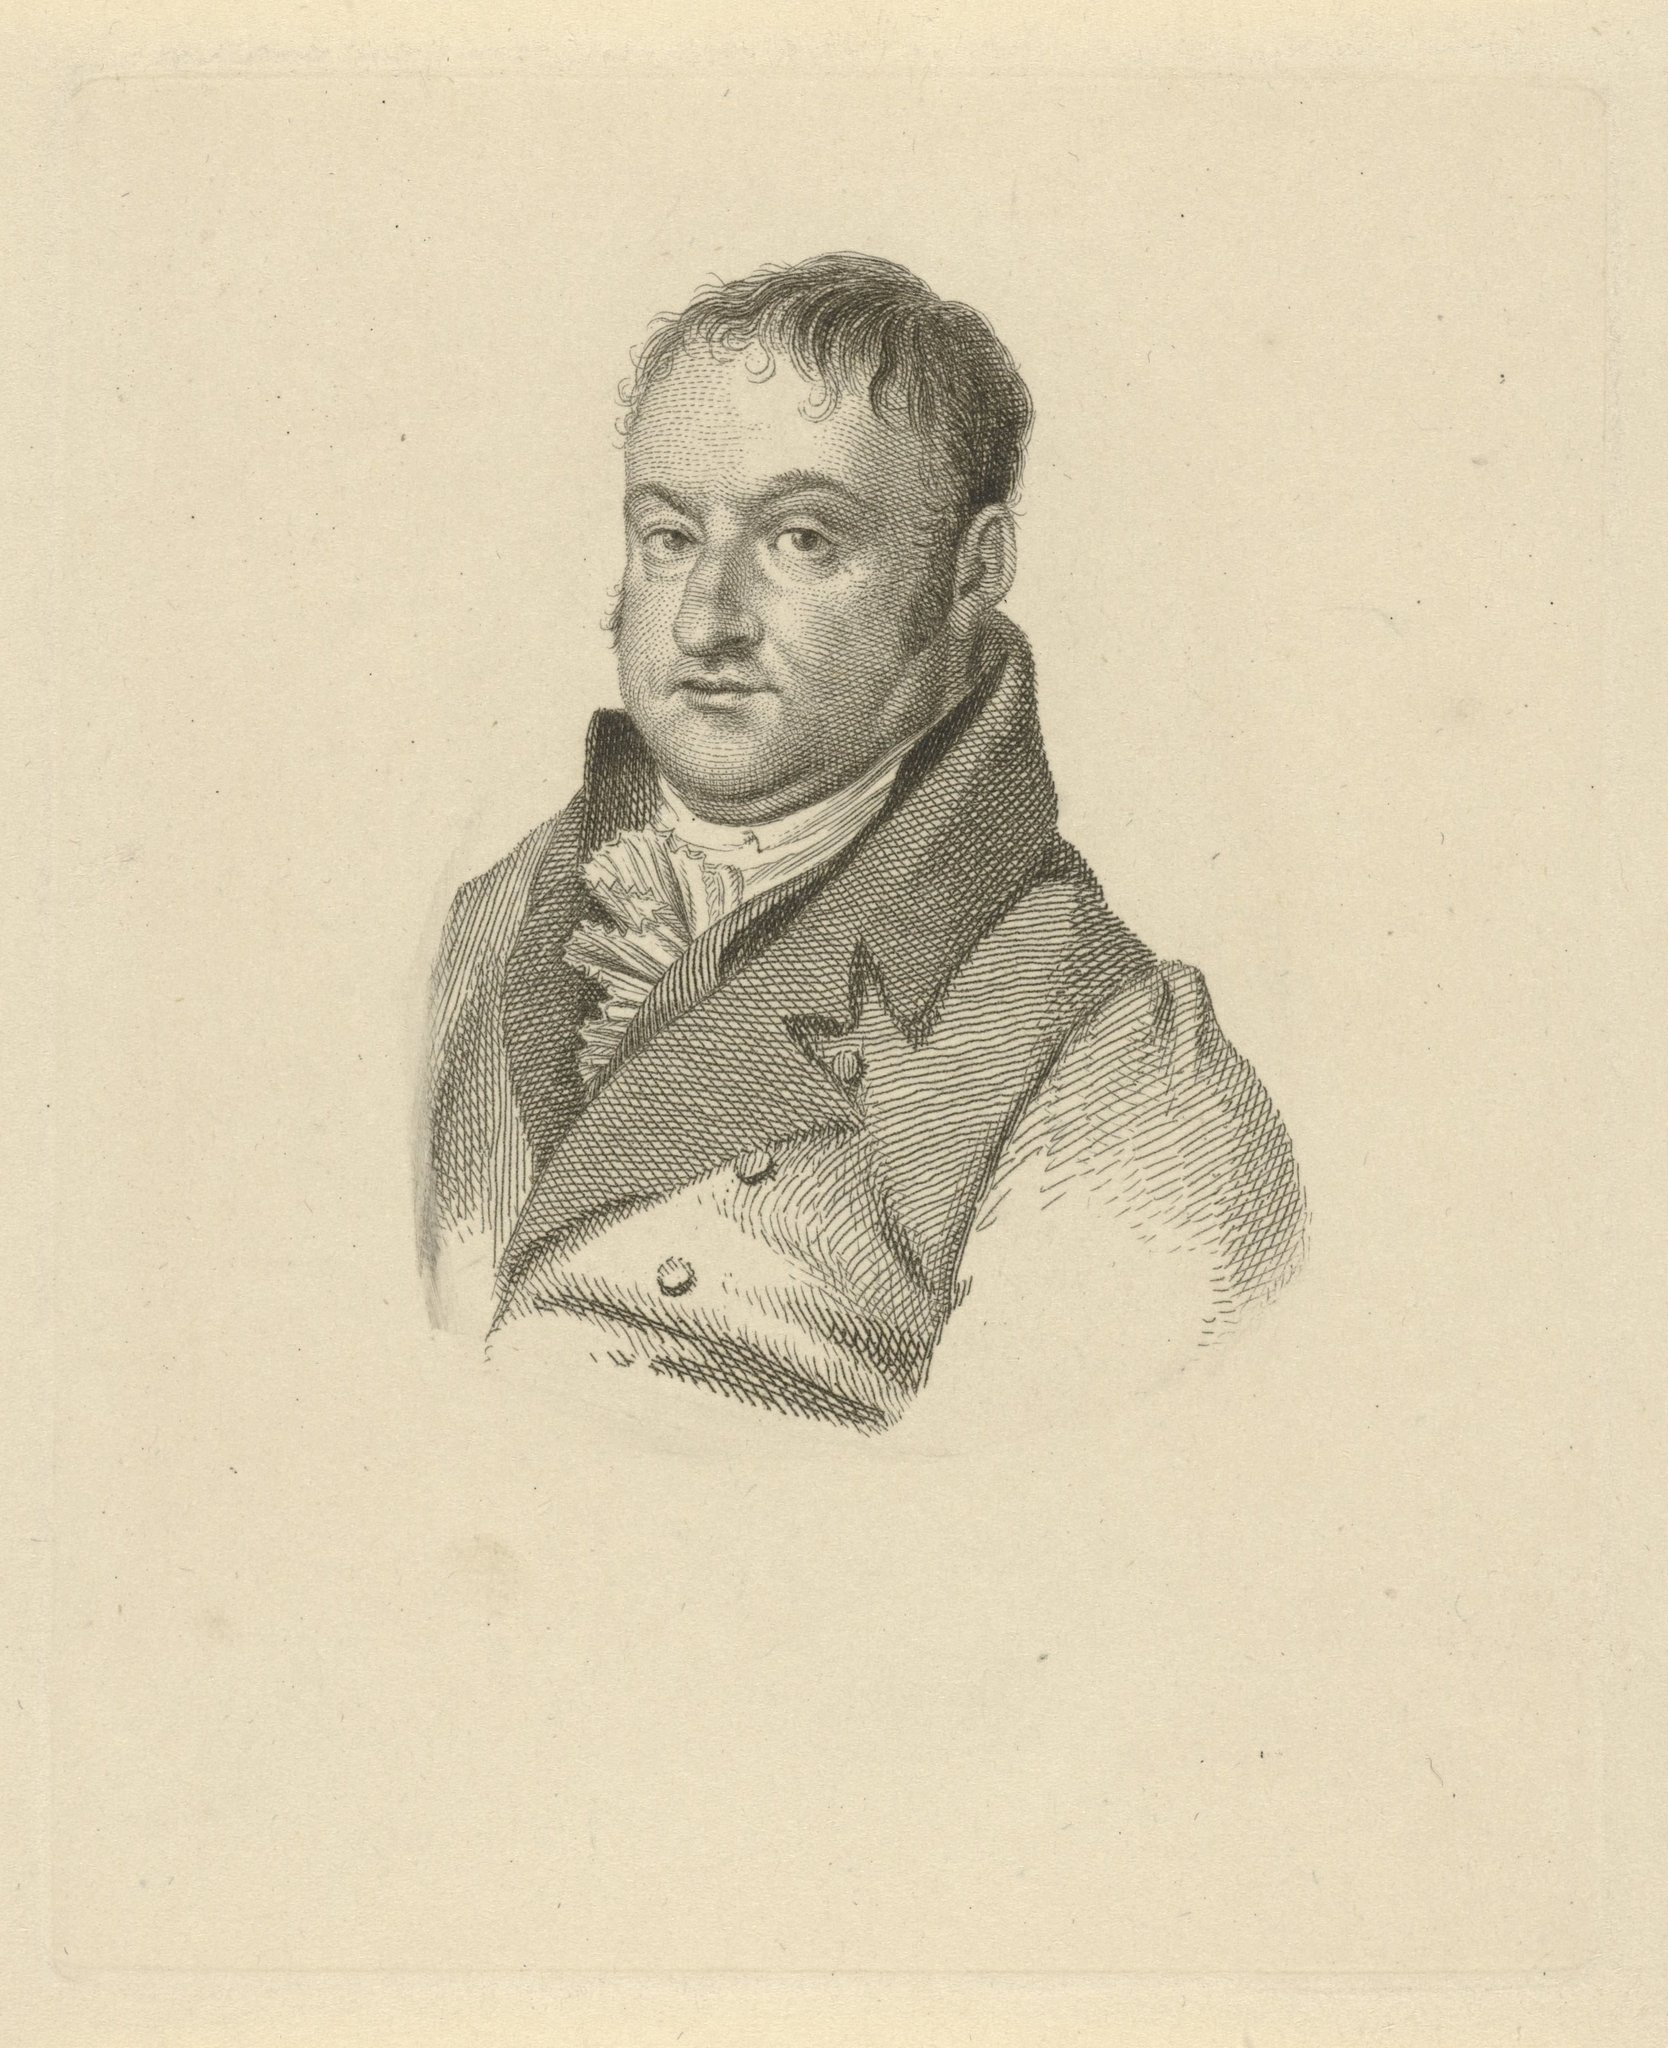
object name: print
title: Portret van Daniel Vrijdag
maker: jacob ernst marcus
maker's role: draughtsman, print maker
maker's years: 1774-1826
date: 1812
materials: paper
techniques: etching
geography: amsterdam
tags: the hague, amsterdam, draughtsman, daniël vrijdag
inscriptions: collector's mark: Lugt 2228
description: Latere staat van de gehele prent gebruikt in: Jacob Ernst Marcus, Etudes gravées. Amsterdam: S. de Grebber, 1826.